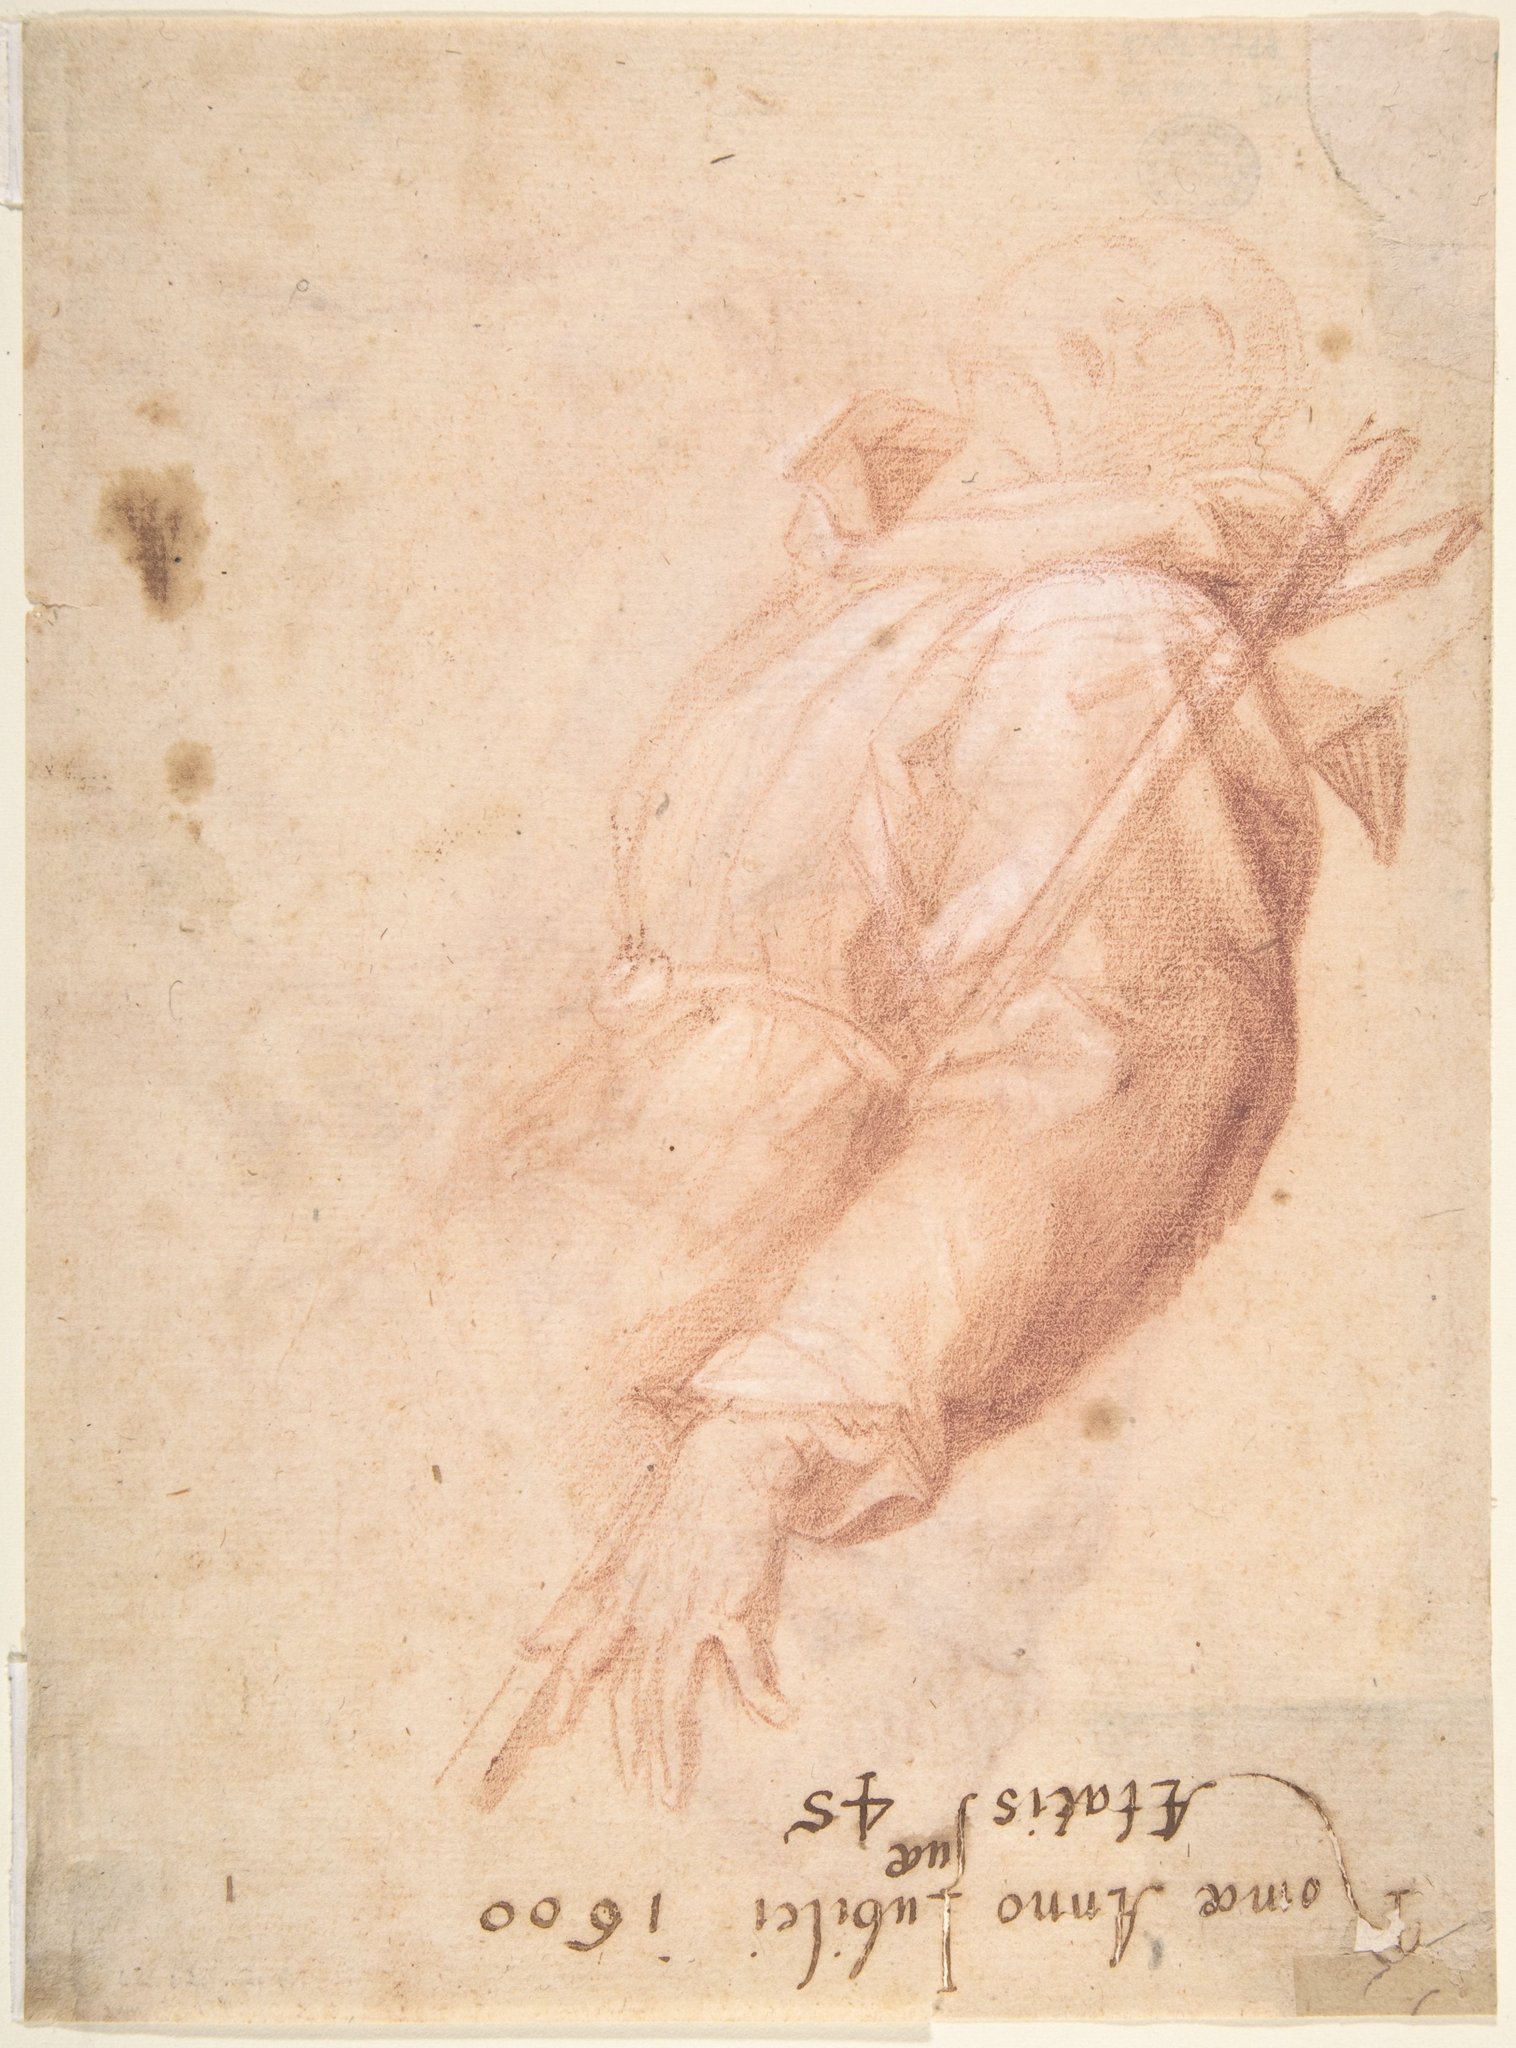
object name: drawing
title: Monk with Crucifix (recto); Monk with Book (verso)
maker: anonymous, italian, 17th century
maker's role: artist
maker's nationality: italian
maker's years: 1600-1700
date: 1600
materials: chalk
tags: cross,monks